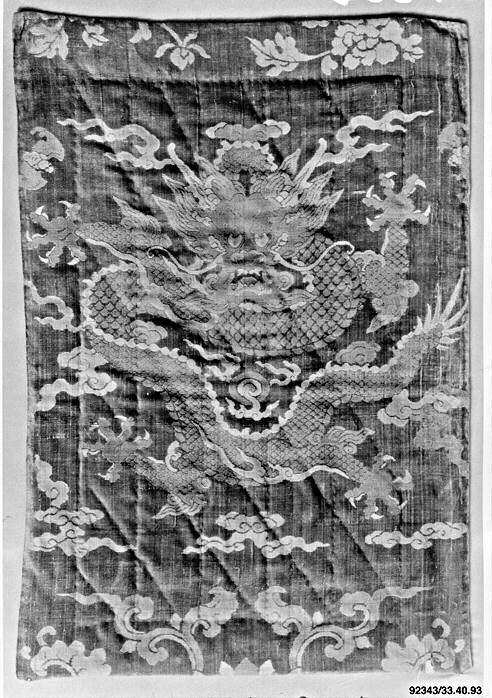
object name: panel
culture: chinese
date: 1368-1644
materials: silk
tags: dragons